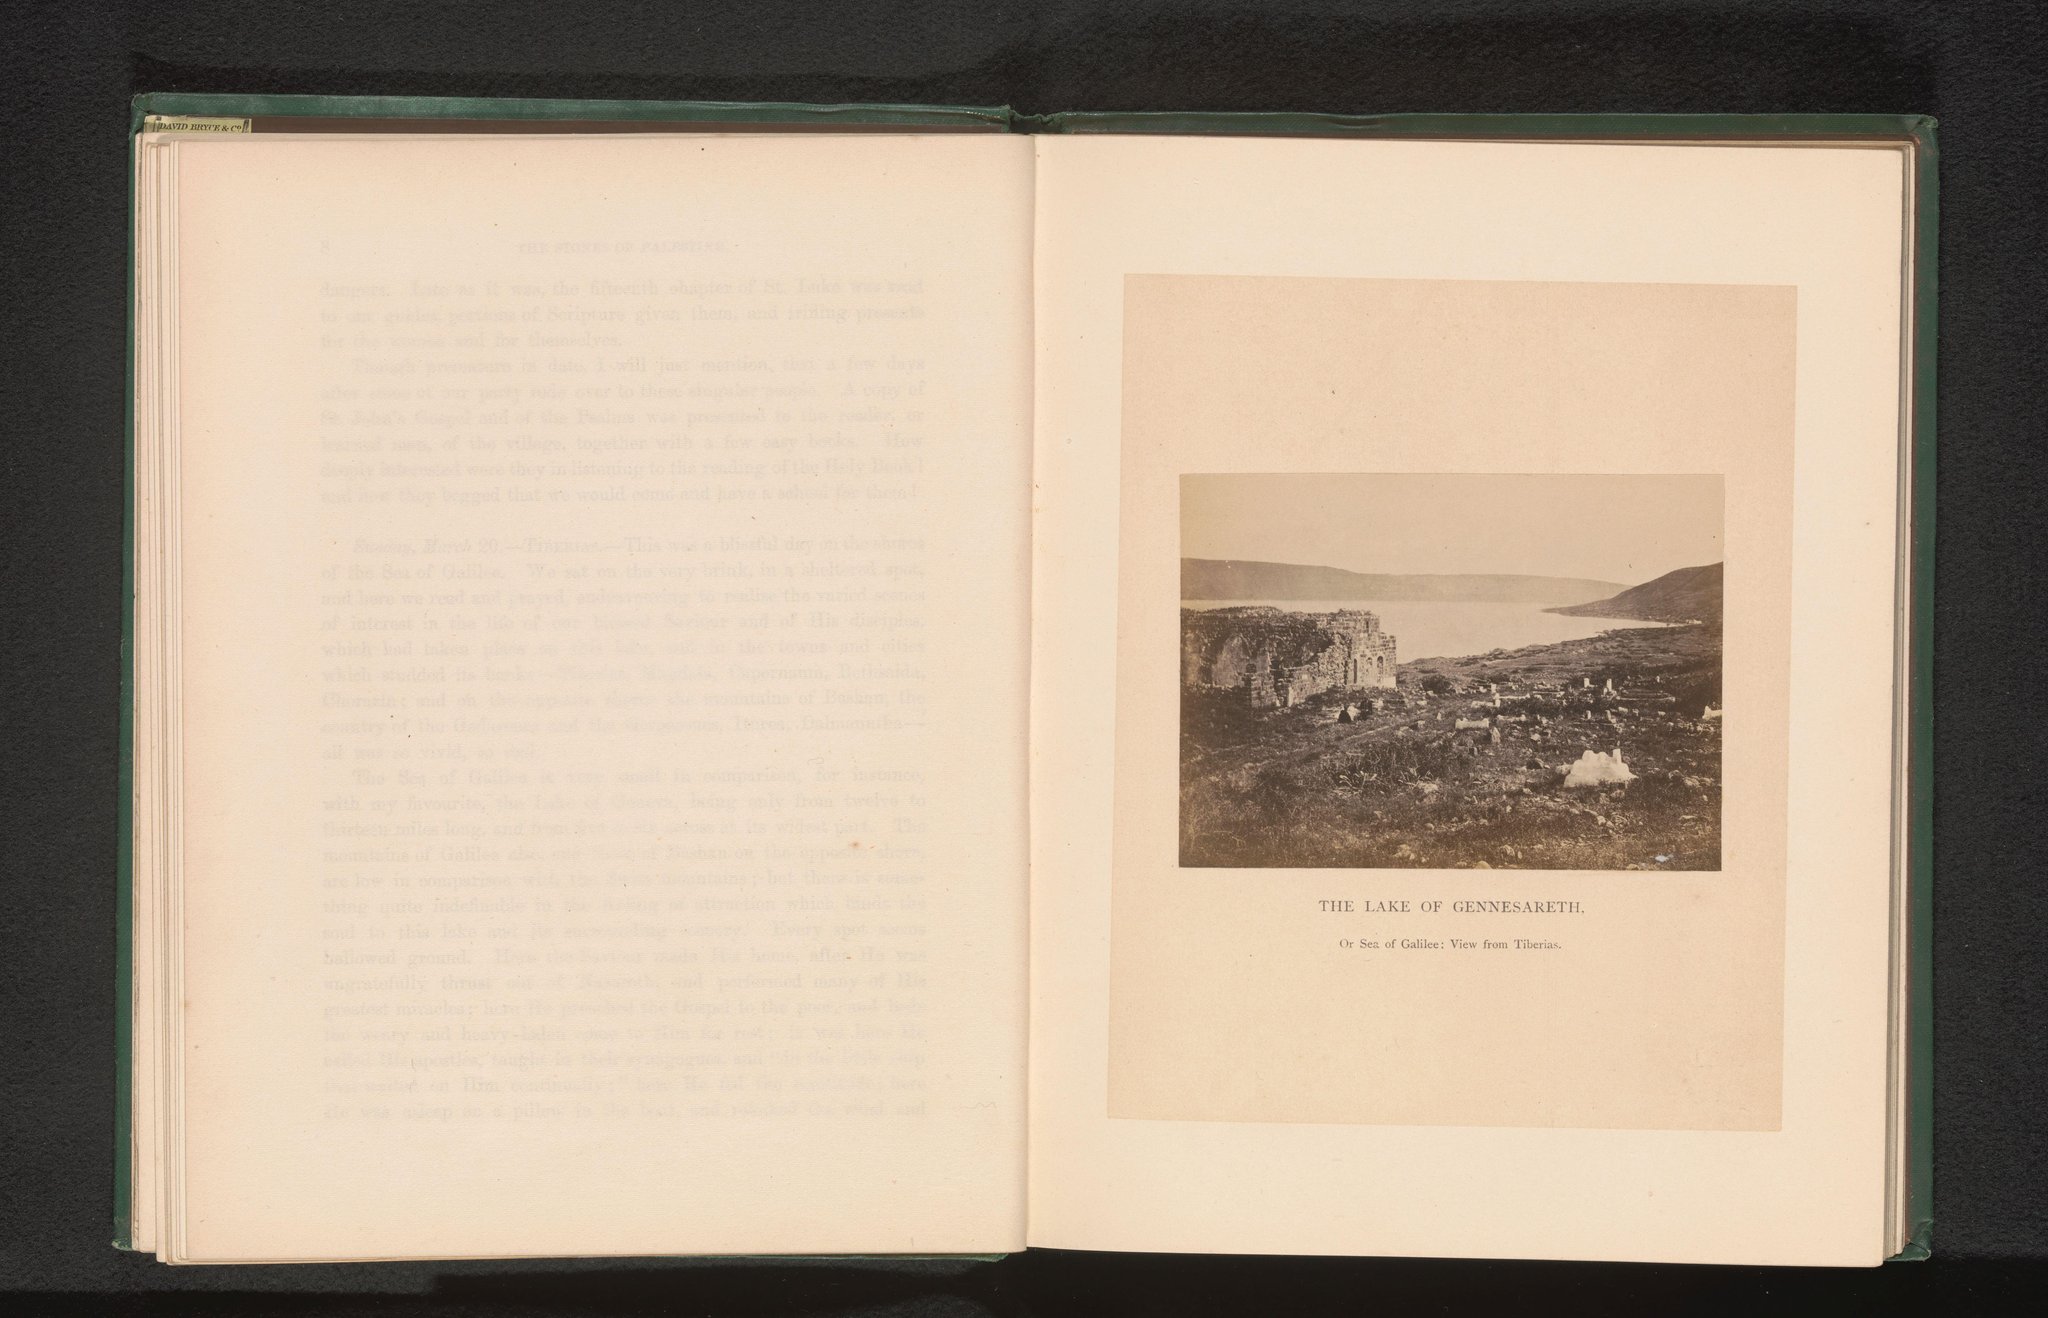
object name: page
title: The Lake of Gennesareth, or Sea of Galilea; view from Tiberias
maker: francis bedford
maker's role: print maker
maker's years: 1815-1894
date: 1860-1865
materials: photographic support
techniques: albumen print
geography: tiberias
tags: lake